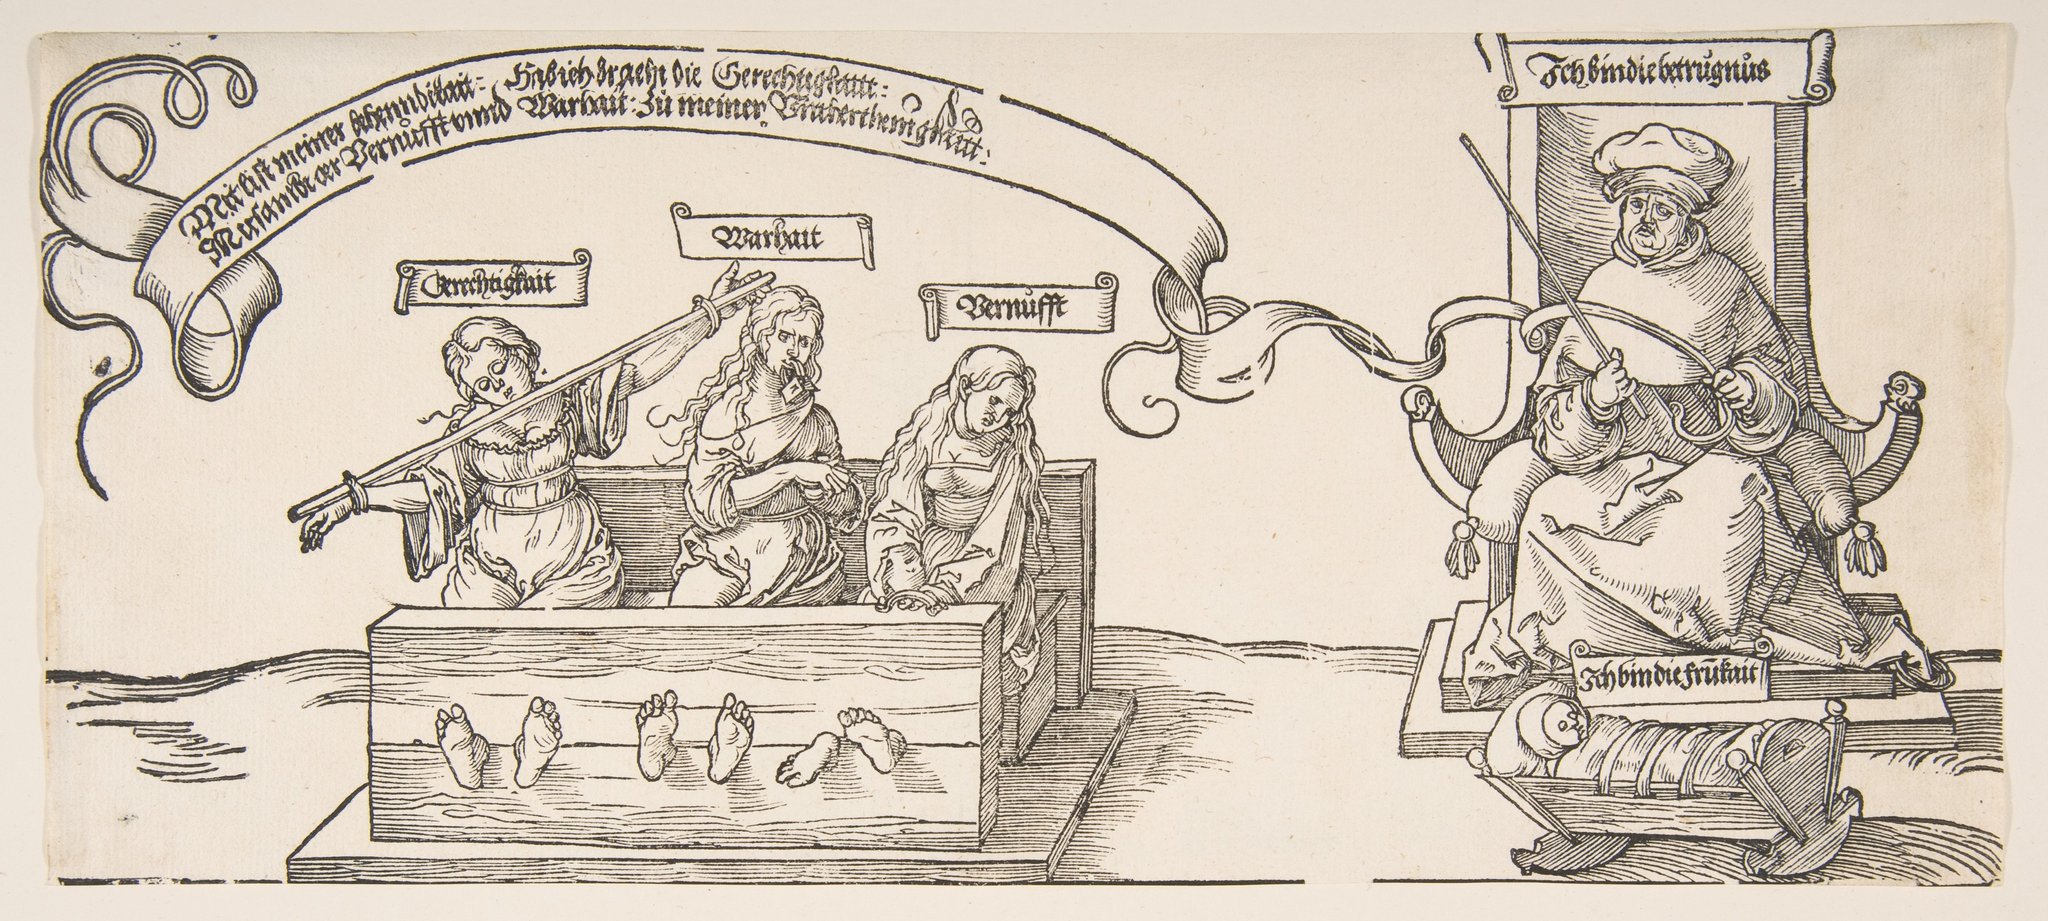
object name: print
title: The Tapestry at Michelfeld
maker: albrecht dürer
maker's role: artist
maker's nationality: german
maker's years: 1471-1528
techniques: woodcut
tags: infants,men,women